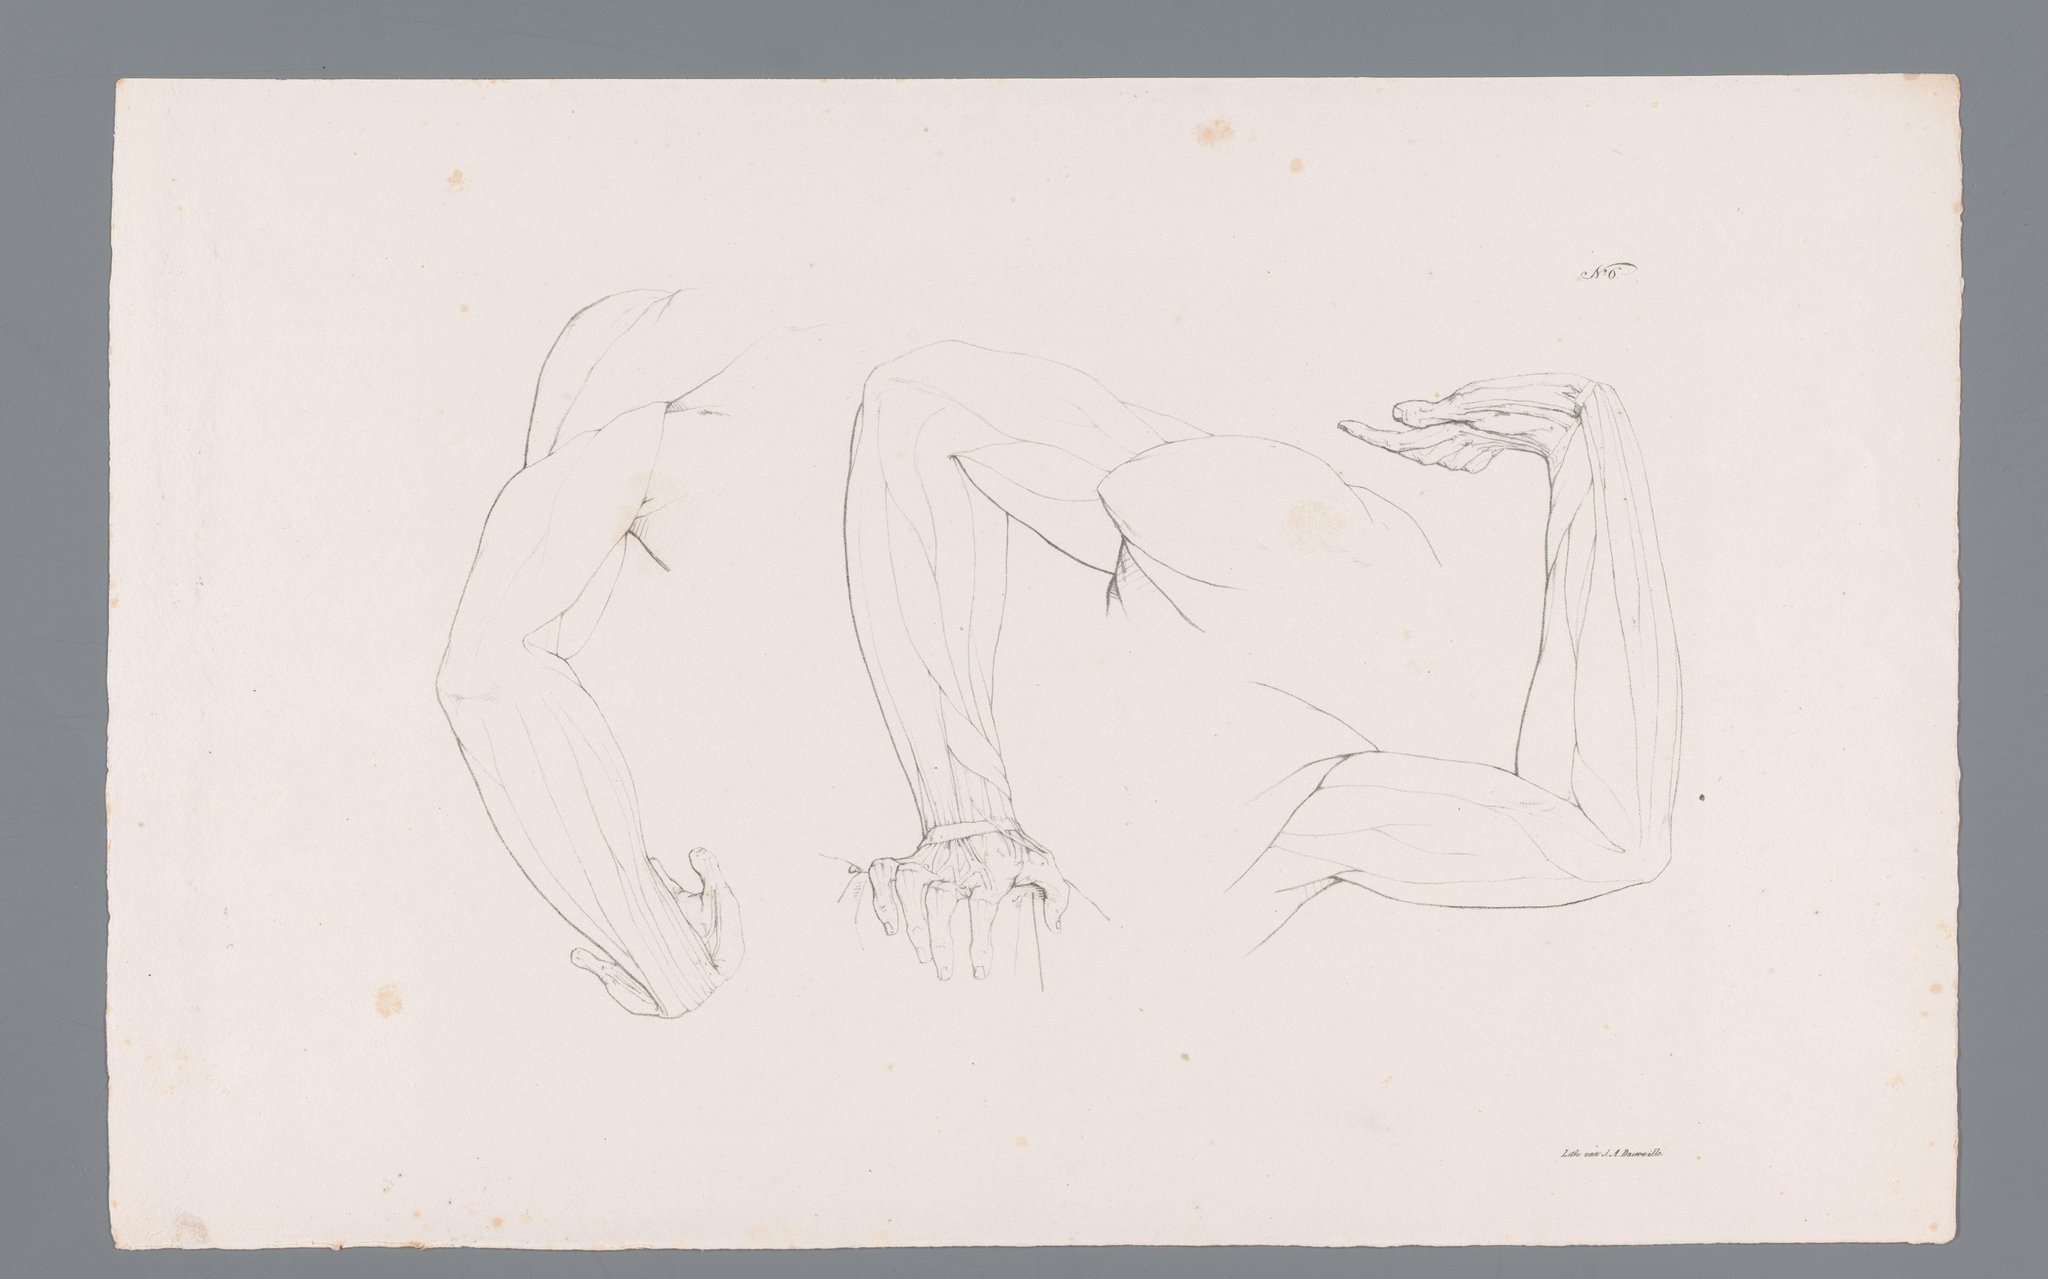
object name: print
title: Drie anatomieën van een gebogen arm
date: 1828-1830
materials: paper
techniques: lithograph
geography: amsterdam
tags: arms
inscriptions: collector's mark: Lugt 2228, watermark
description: Onderdeel van een omslag met in totaal achttien anatomische voorstellingen.